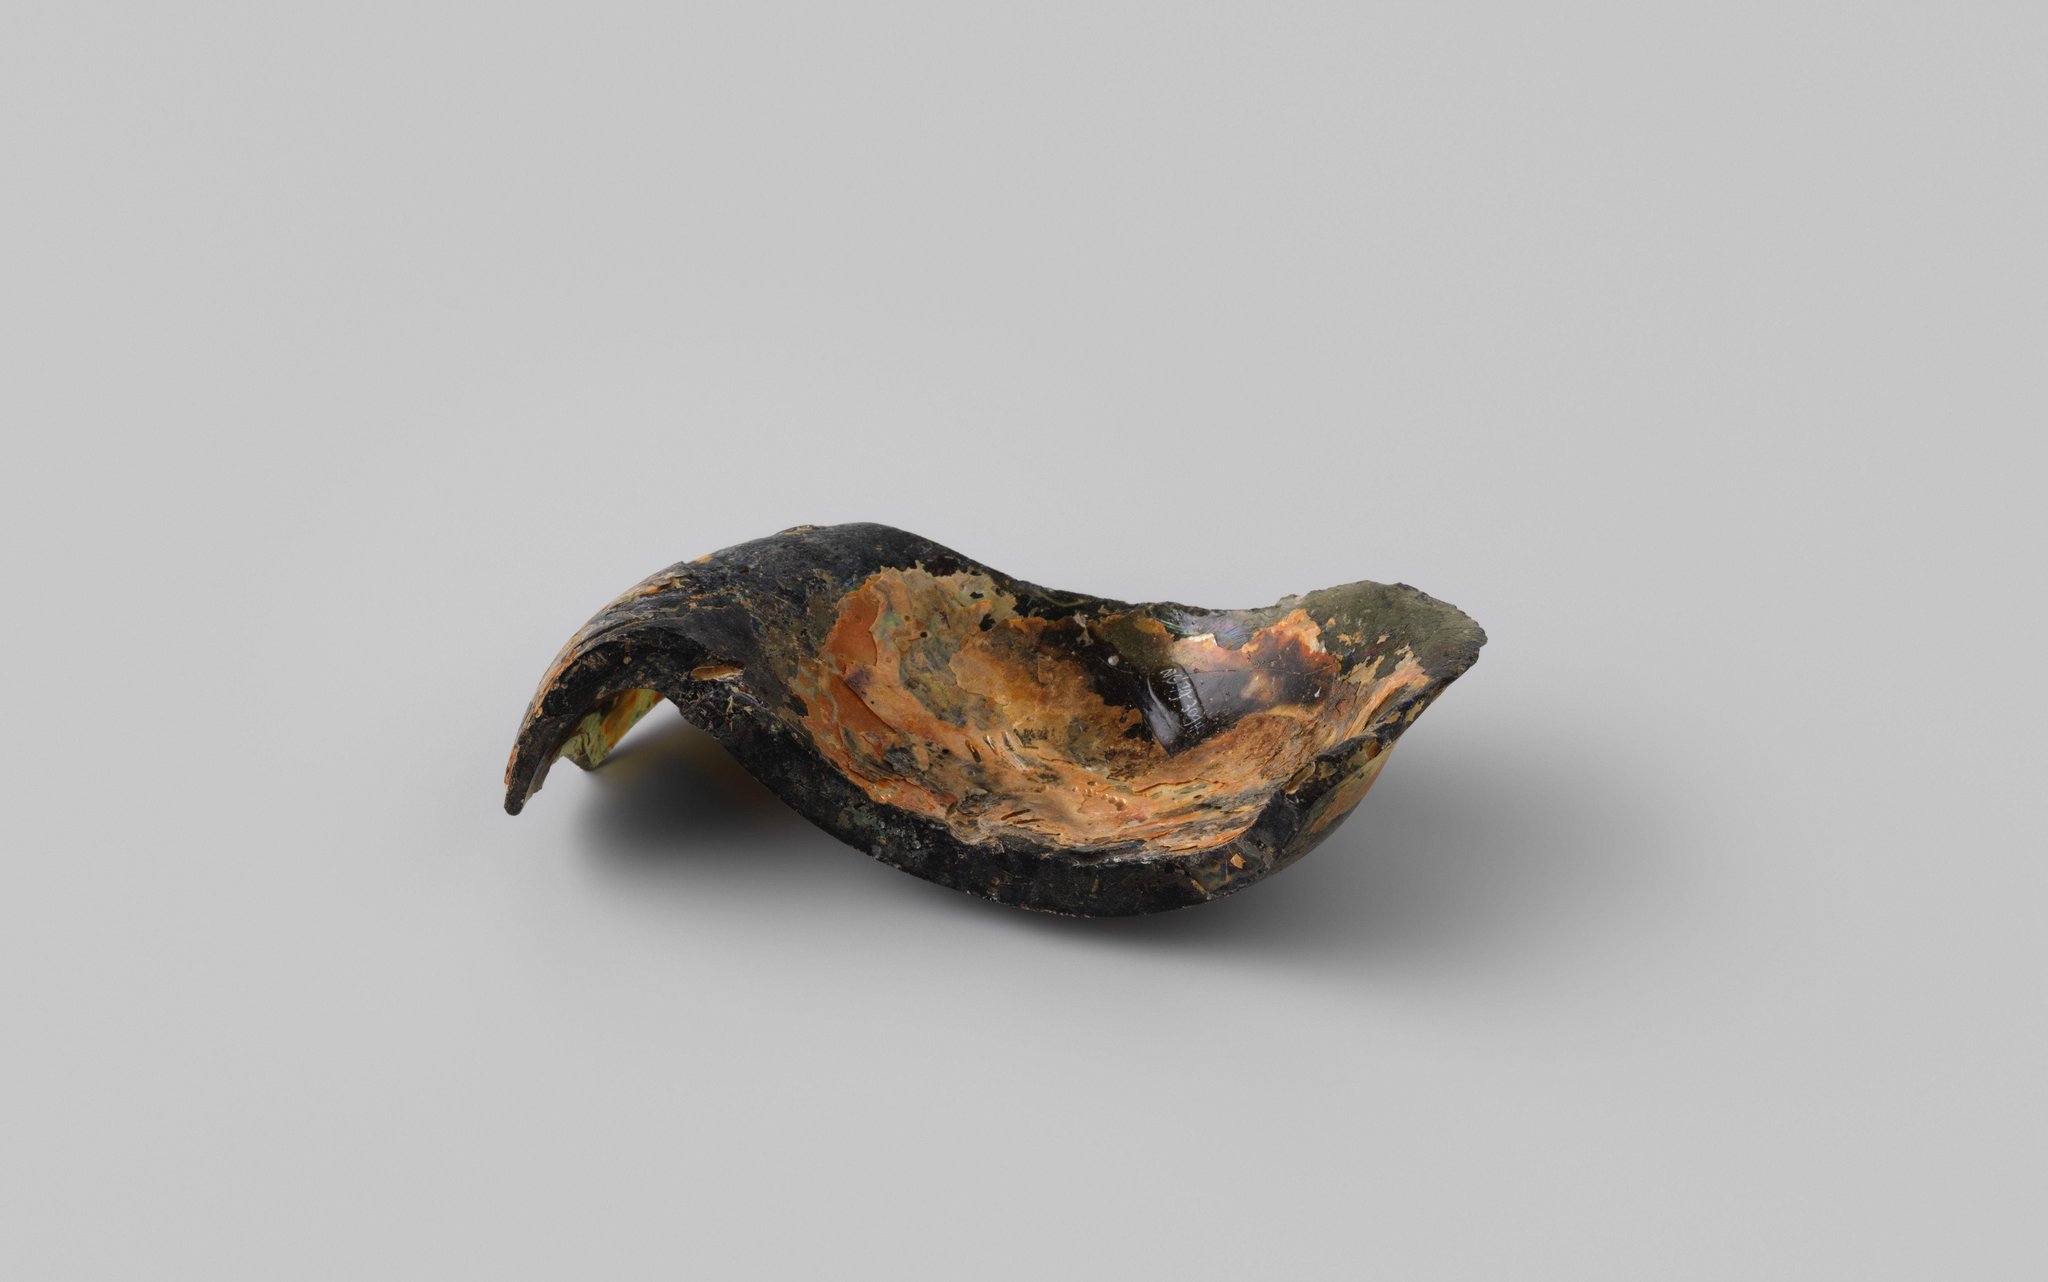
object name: sherd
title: Bodemfragment wijnfles uit het wrak van de Oost-Indiëvaarder Hollandia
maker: Anonymous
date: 1700-1743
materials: glass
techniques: green glass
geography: netherlands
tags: verenigde oostindische compagnie, hollandia (schip), annet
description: Onion-shaped bottle or bottle with vertical side, base, fragm, eroded, cs-kick-up. Continental production.